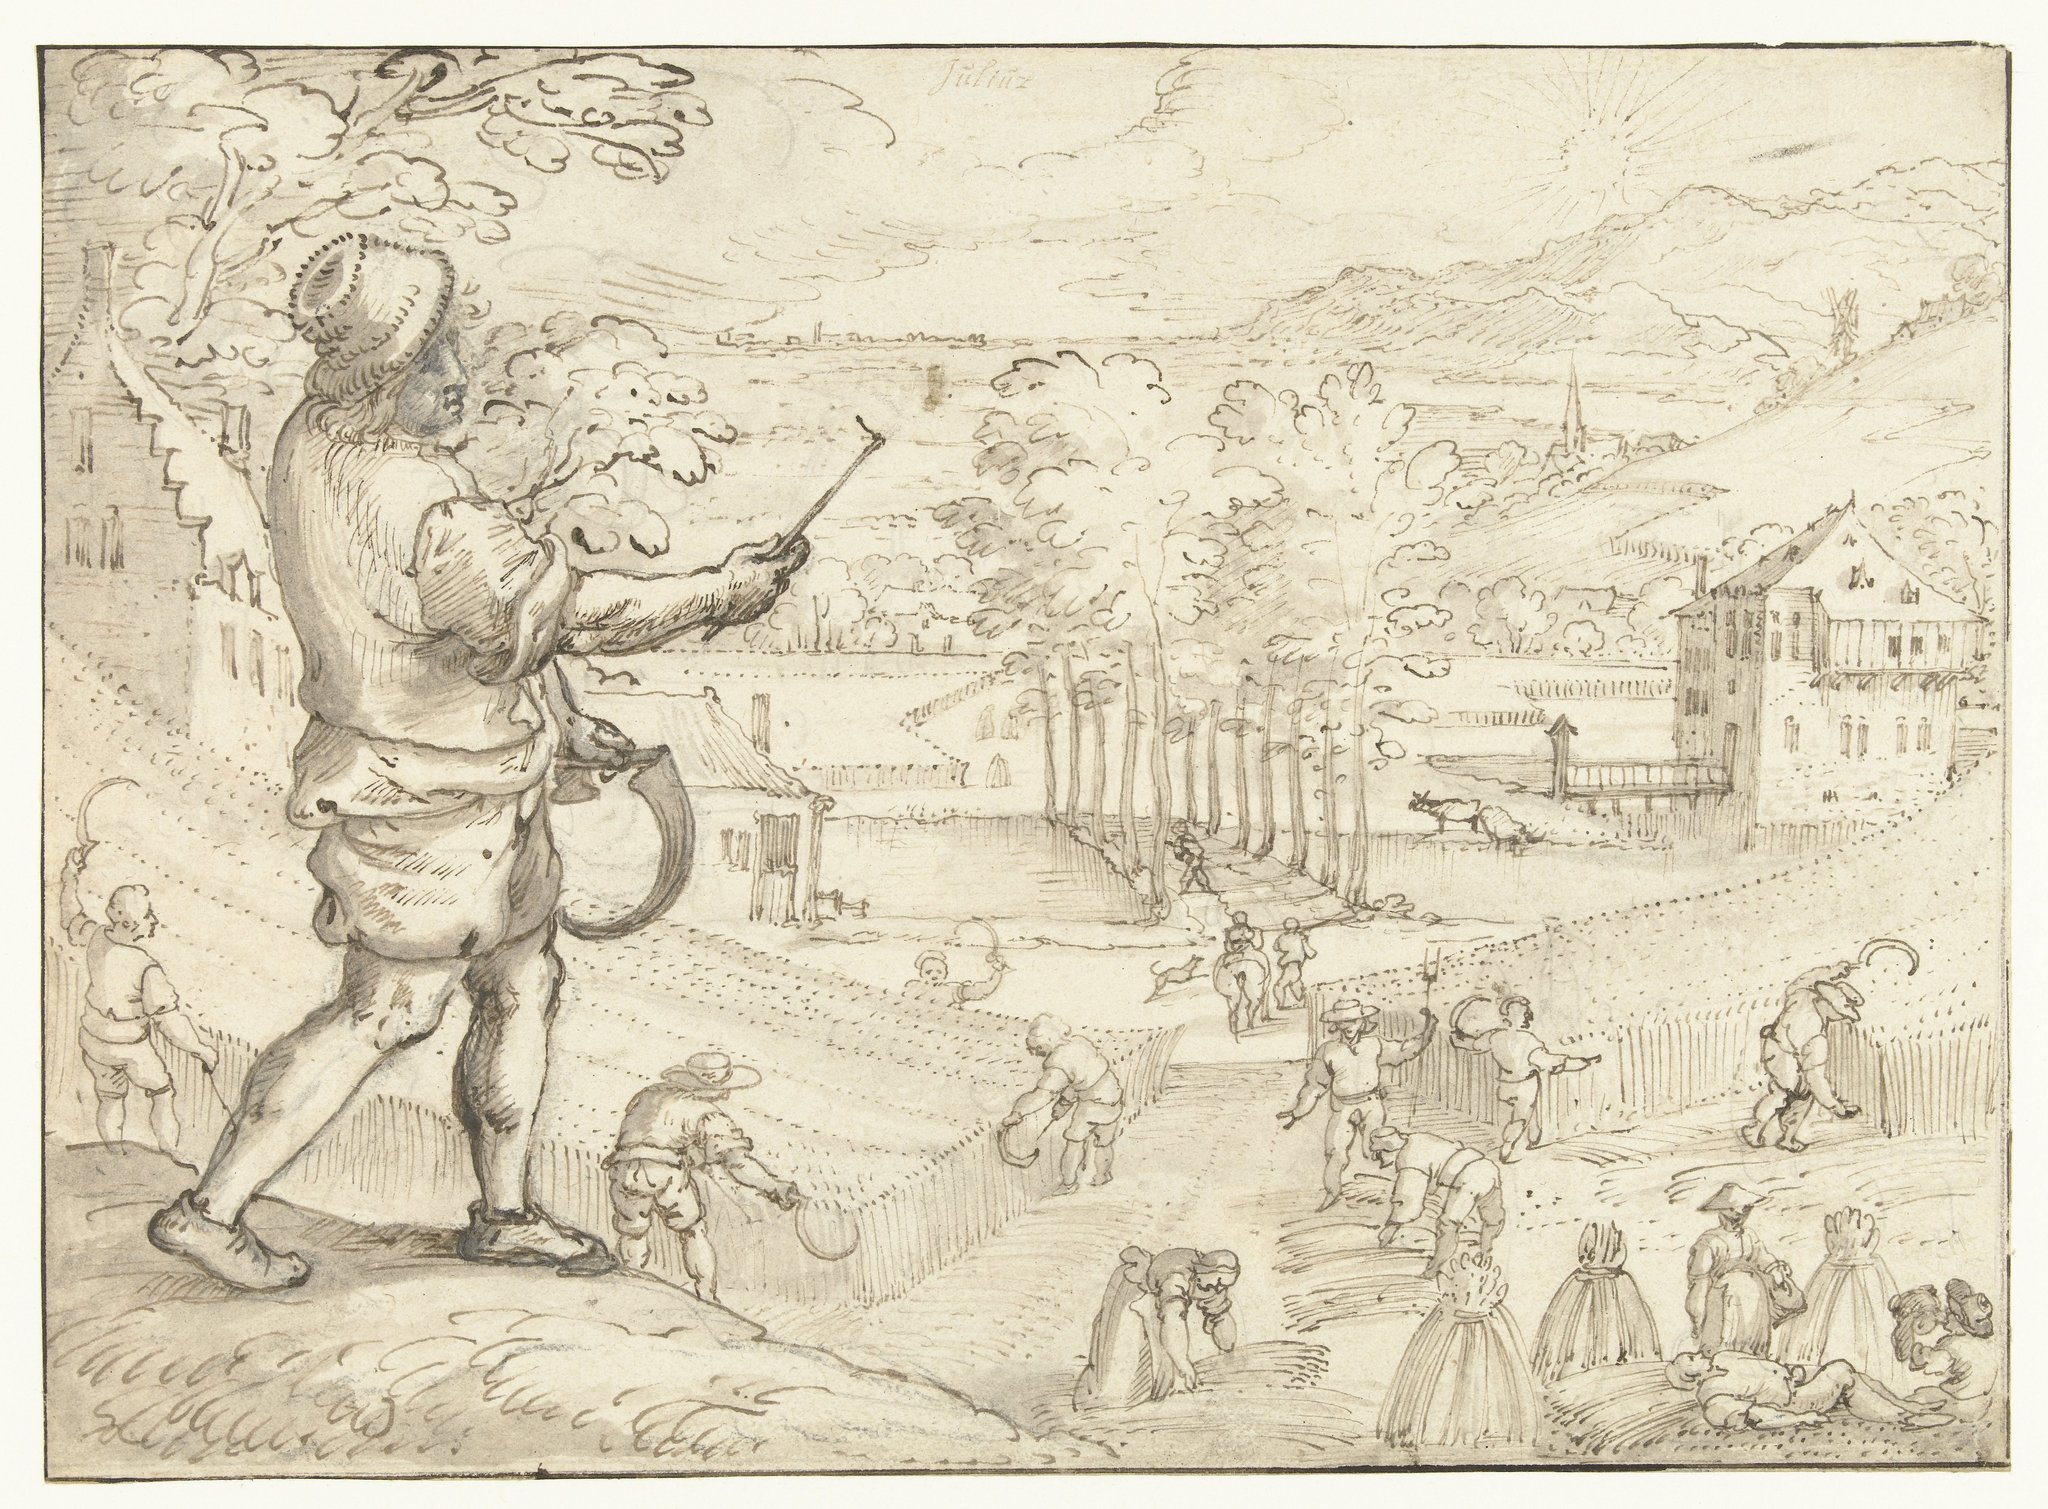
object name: drawing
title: Twaalf maanden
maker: joos de momper (ii)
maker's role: draughtsman, painter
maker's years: 1564-1635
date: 1590-1610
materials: chalk, ink, paper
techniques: brush, pen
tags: harvest, july and its 'labours', agricultural implements: sickle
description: De maand juli. Man met sikkel, rechts het oogsten van vlas. Ontwerp voor een prent.